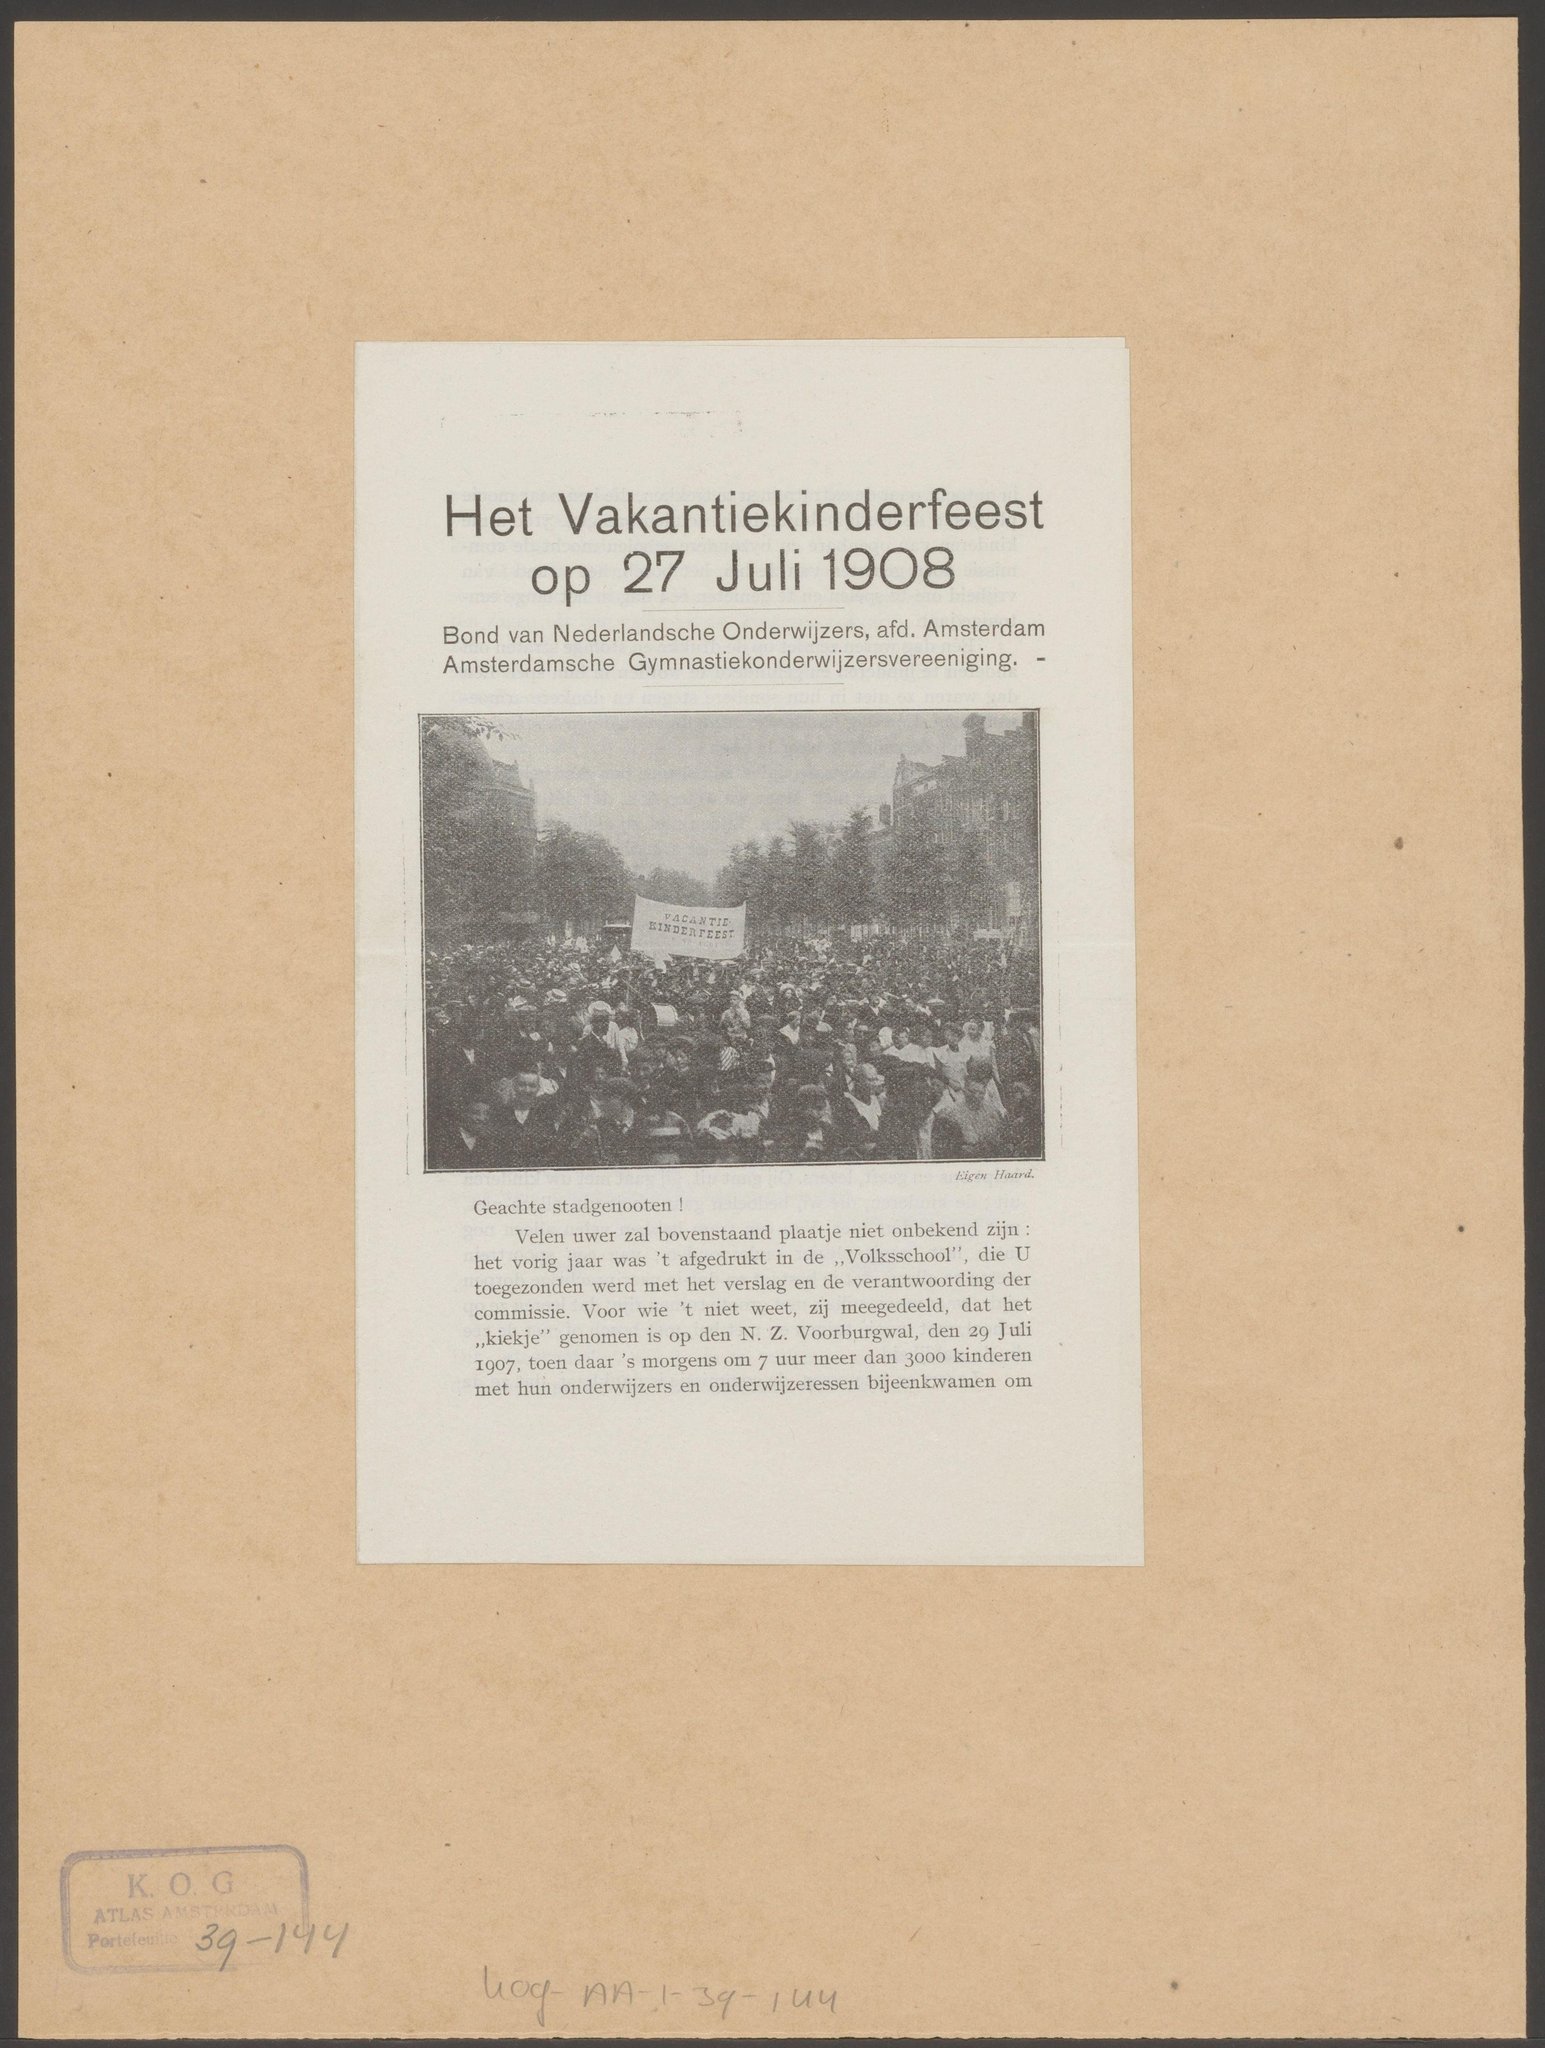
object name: photomechanical print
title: Het Vakantiekinderfeest op 27 Juli 1908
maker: Anonymous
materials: paper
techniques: letterpress printing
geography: netherlands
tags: crowd, mob, child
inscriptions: collector's mark: Lugt 1641b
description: Object bestaat uit een bifolium. Onderwerpsrubriek binnen de Atlas Amsterdam: Armwezen en liefdadige instellingen: IV. Prenten betrekking hebbende op Philantropie.